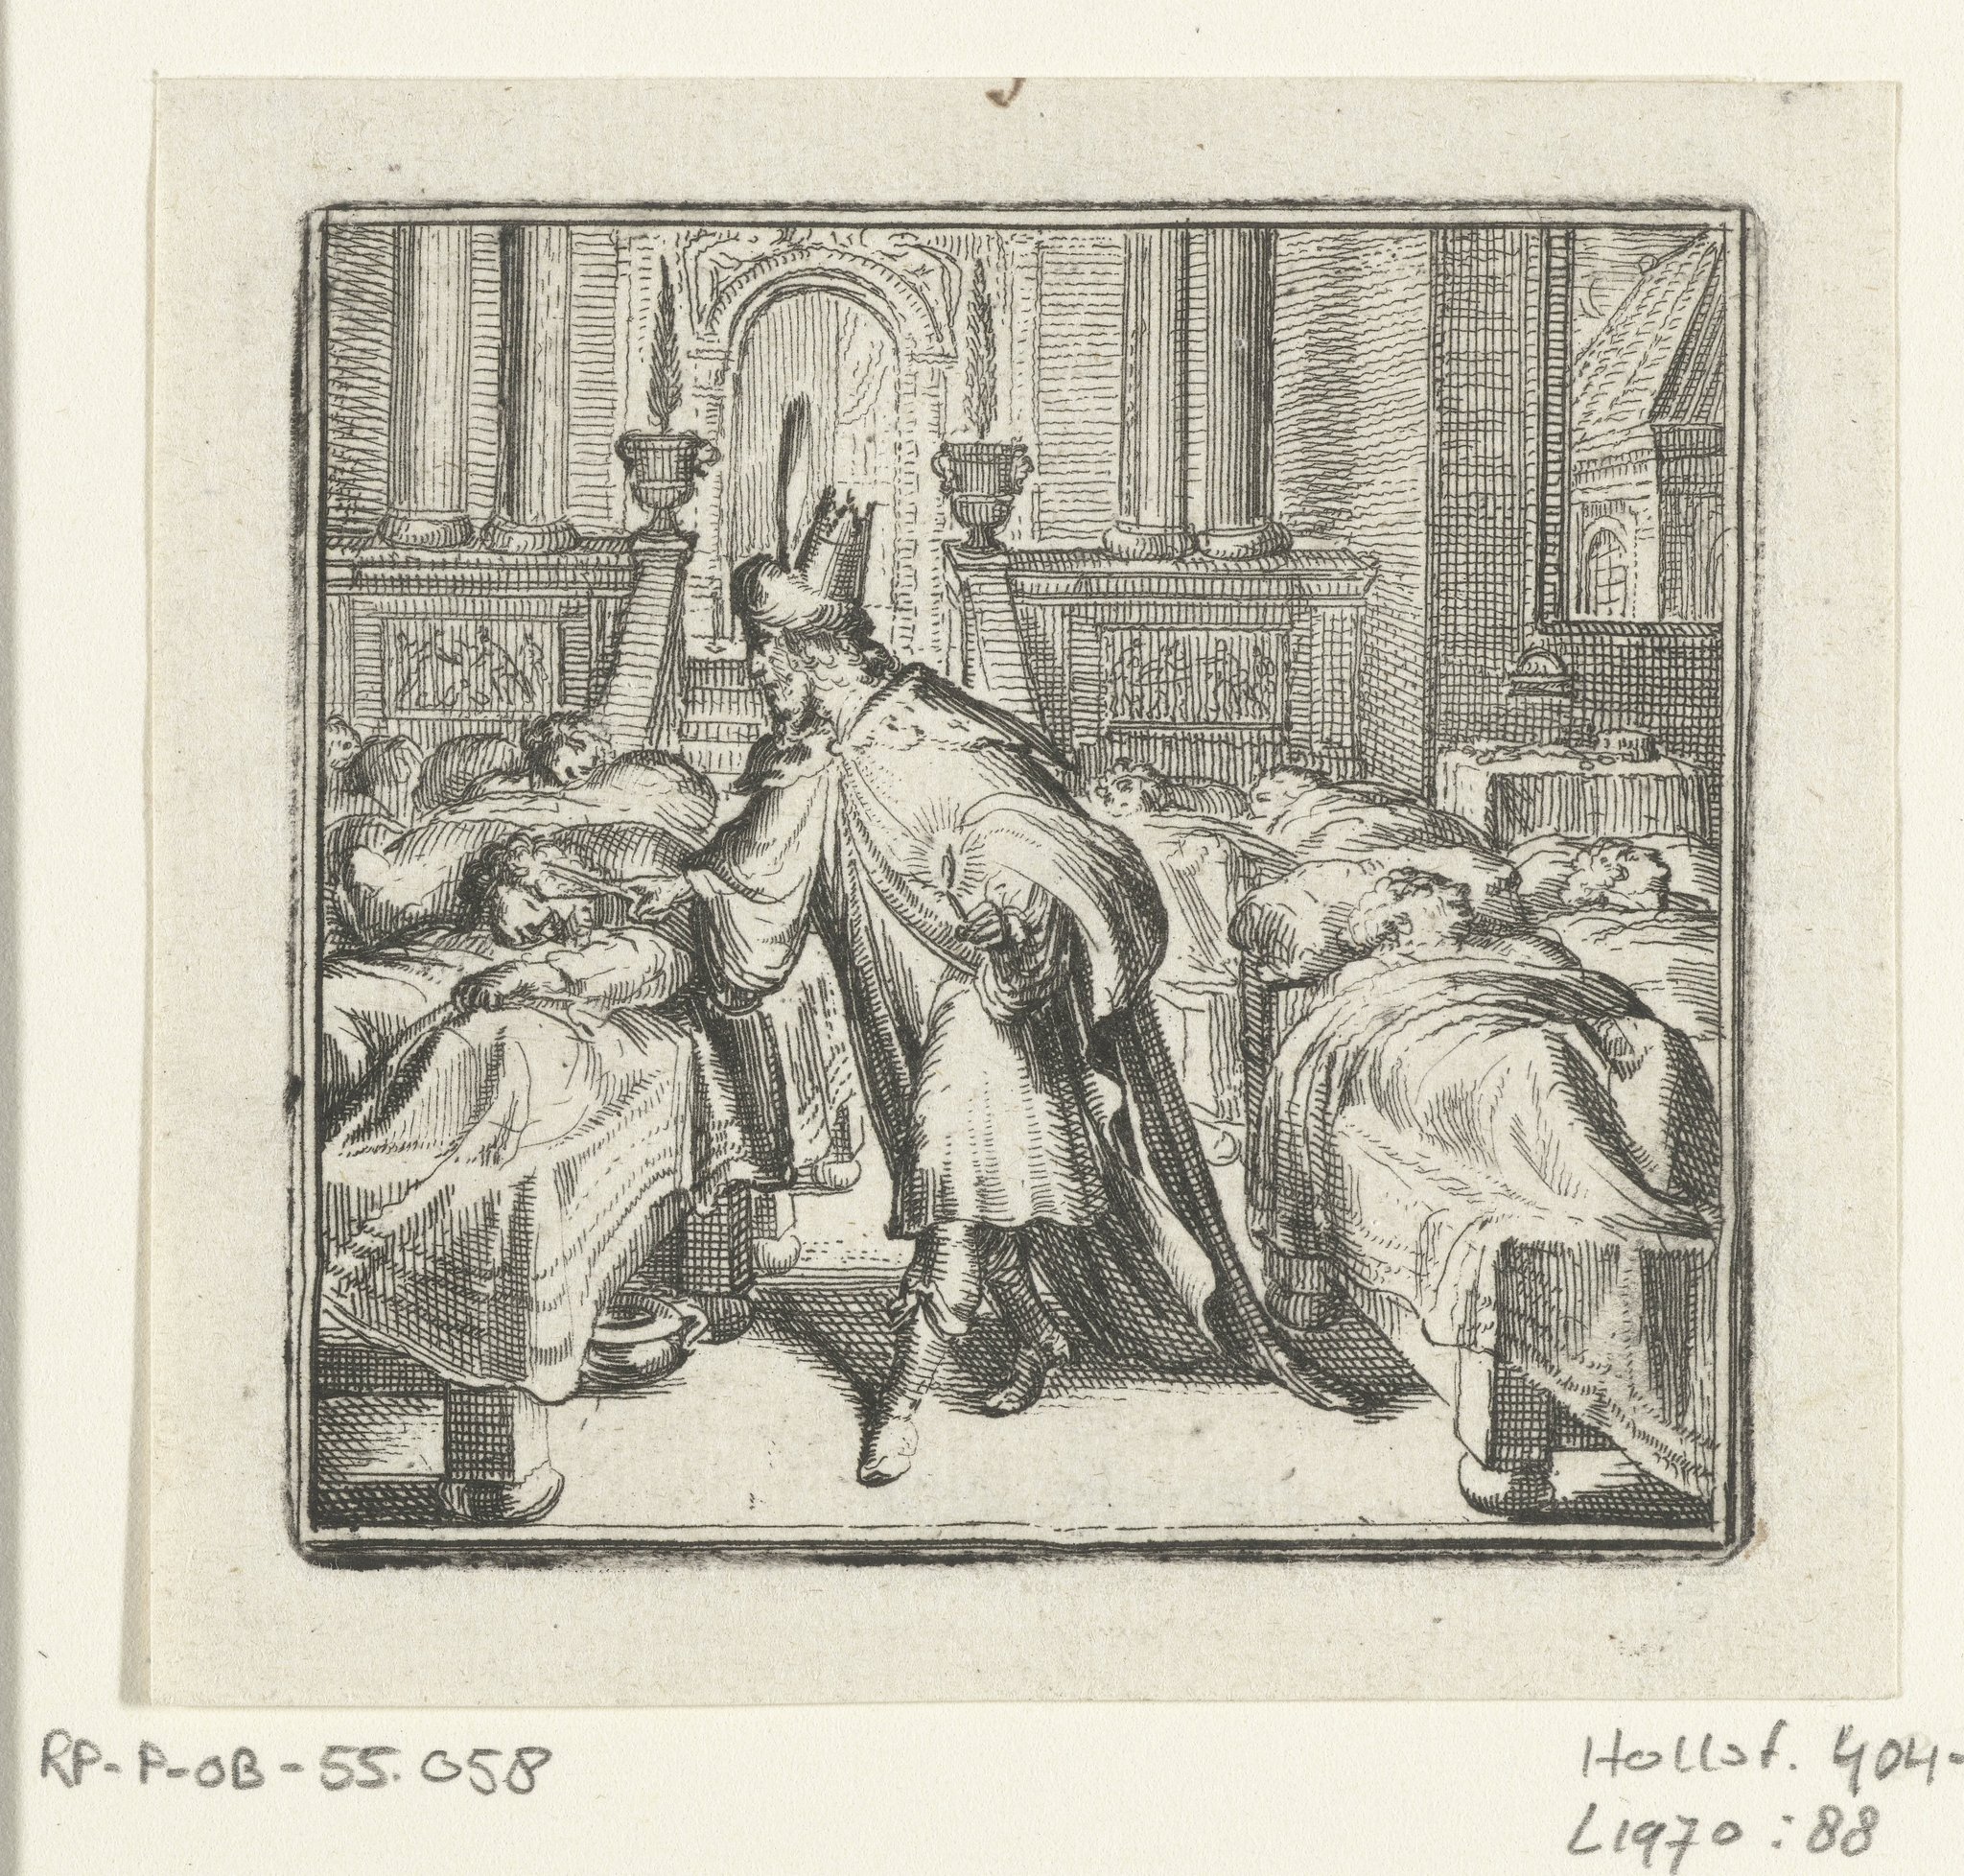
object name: print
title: Illustratie voor de Decamerone van Boccaccio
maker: romeyn de hooghe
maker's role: draughtsman, goldsmith, painter, print maker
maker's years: 1645-1708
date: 1697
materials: paper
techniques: etching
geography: netherlands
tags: (scenes from) specific works of literature: boccaccio, decamerone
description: Illustratie voor: Contes et nouvelles de Bocace Florentin. Traduction libre, 2 delen, Amsterdam, George Gallet, 1697. Latere edities met dezelfde illustraties uit 1699, 1702, 1732.